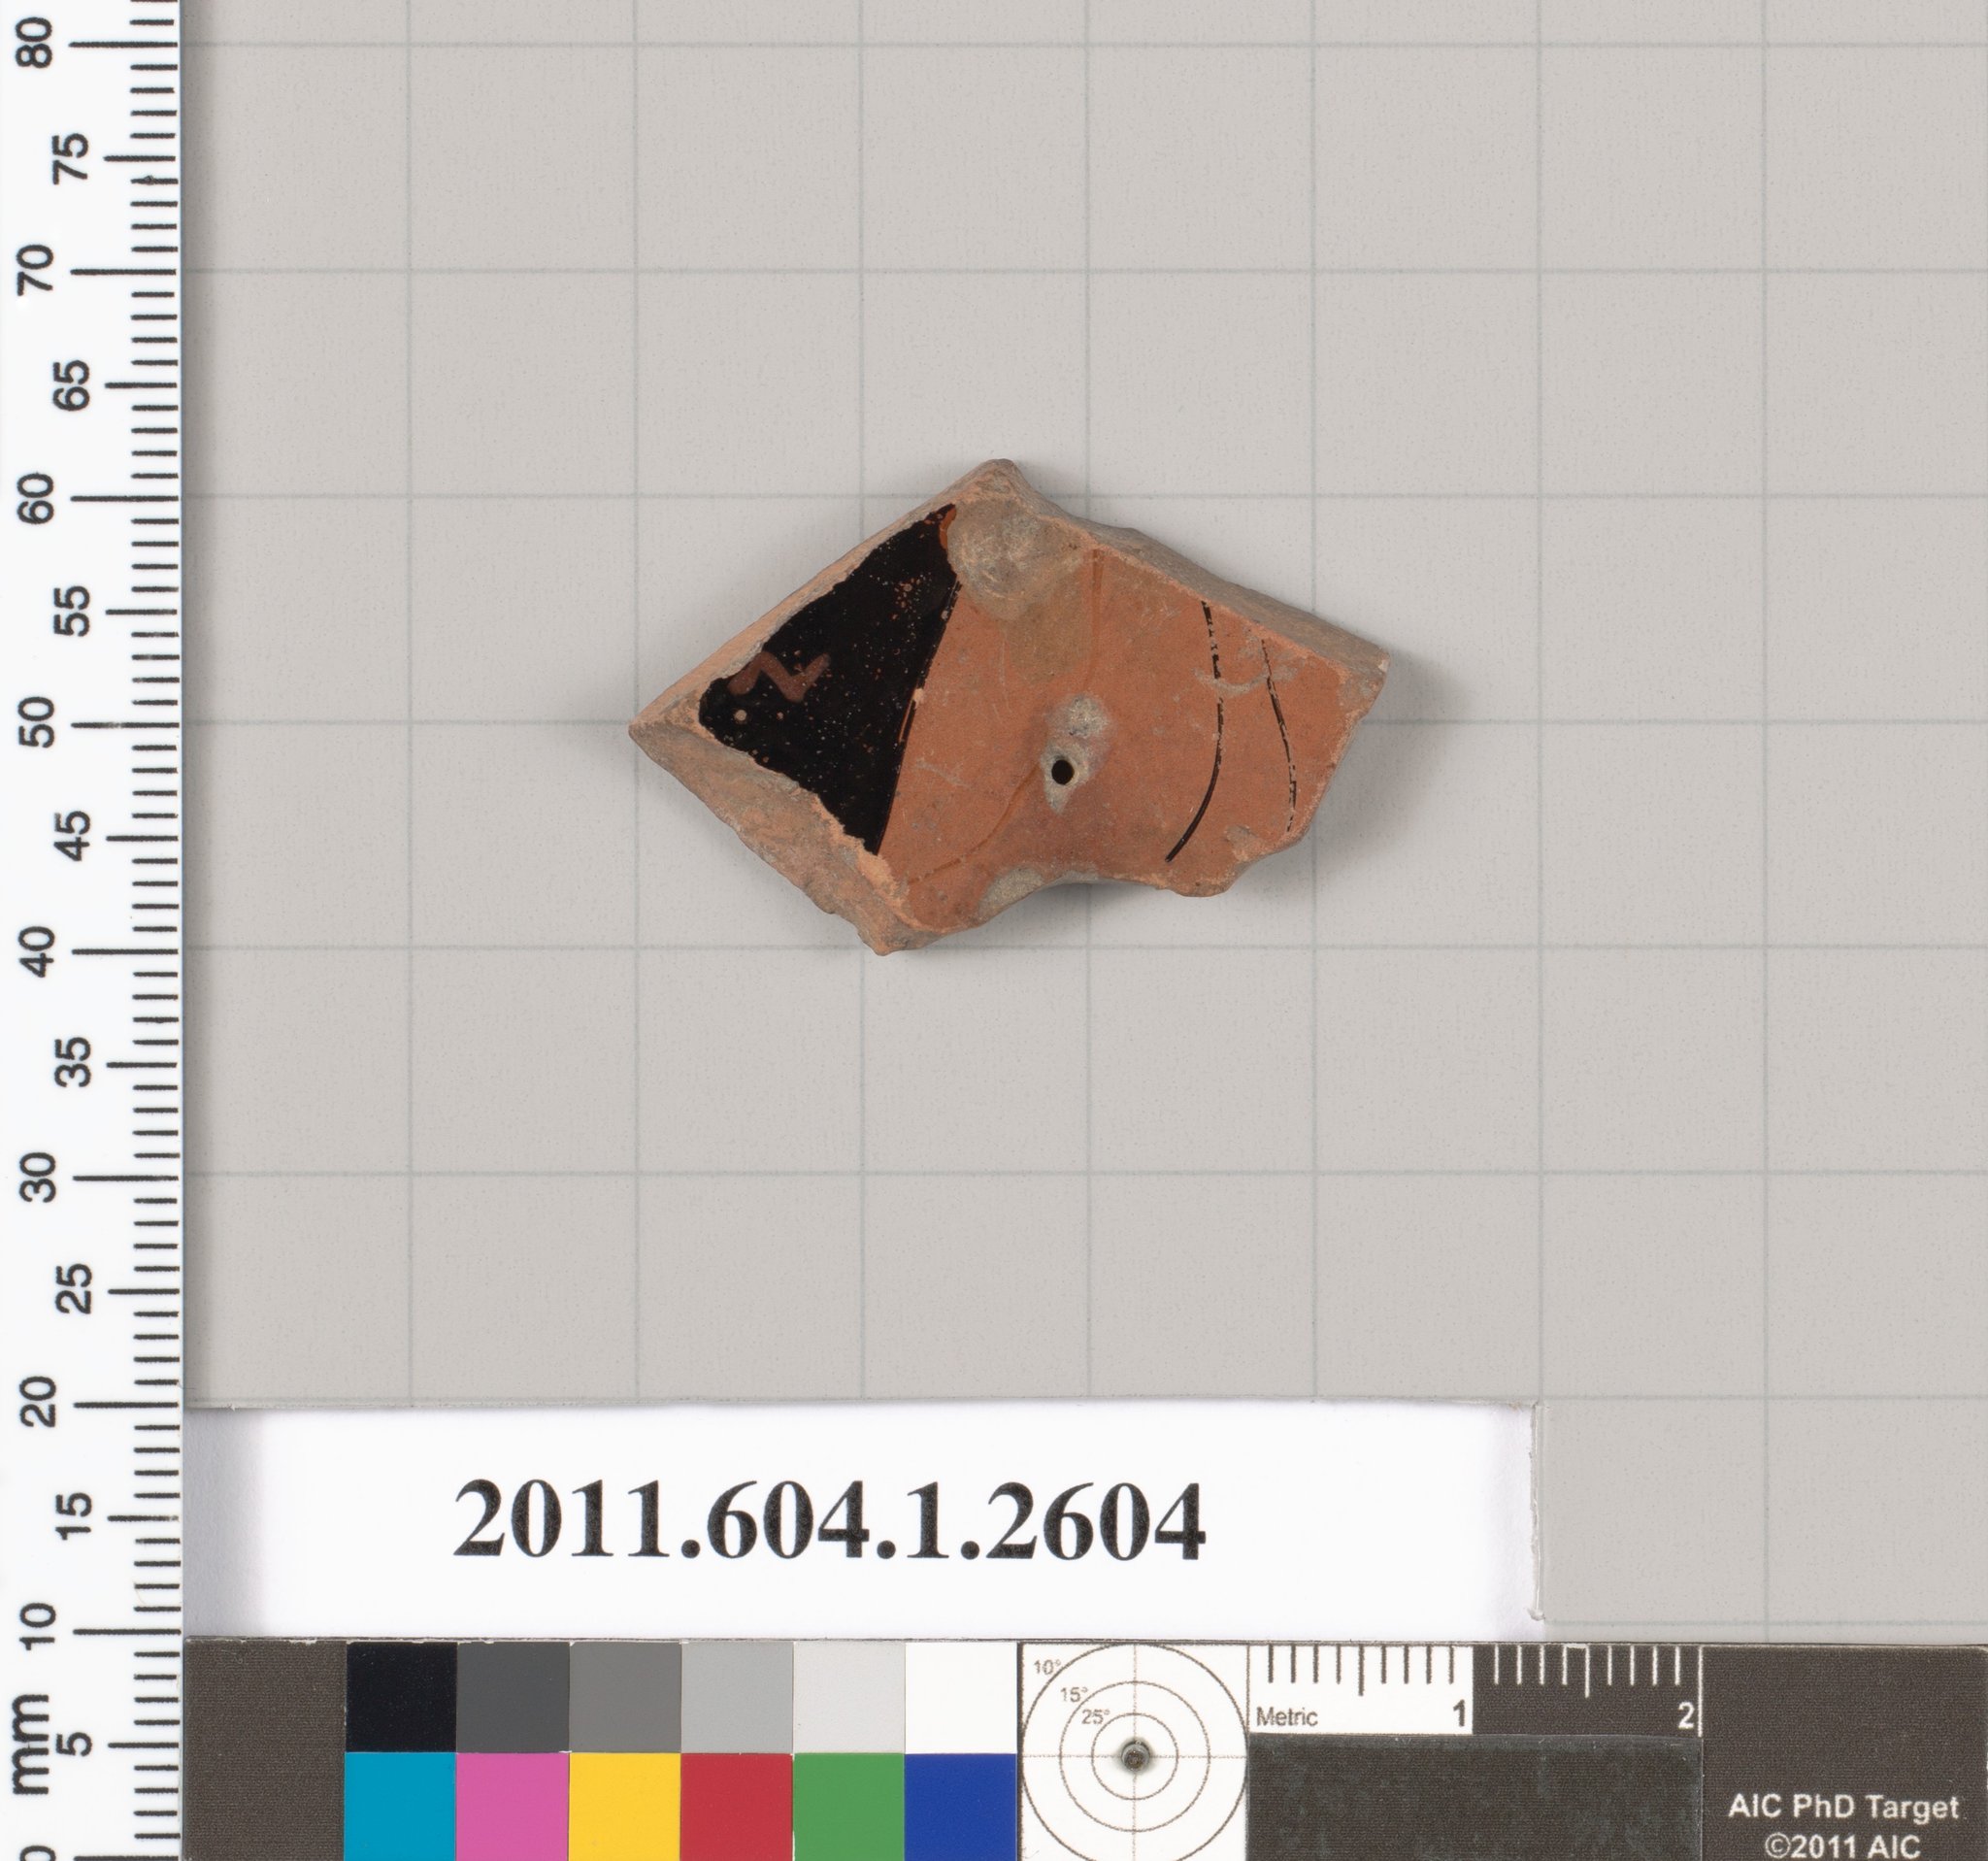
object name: kylix fragment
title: Terracotta fragment of a kylix (drinking cup)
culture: greek, attic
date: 500-451 BCE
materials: terracotta